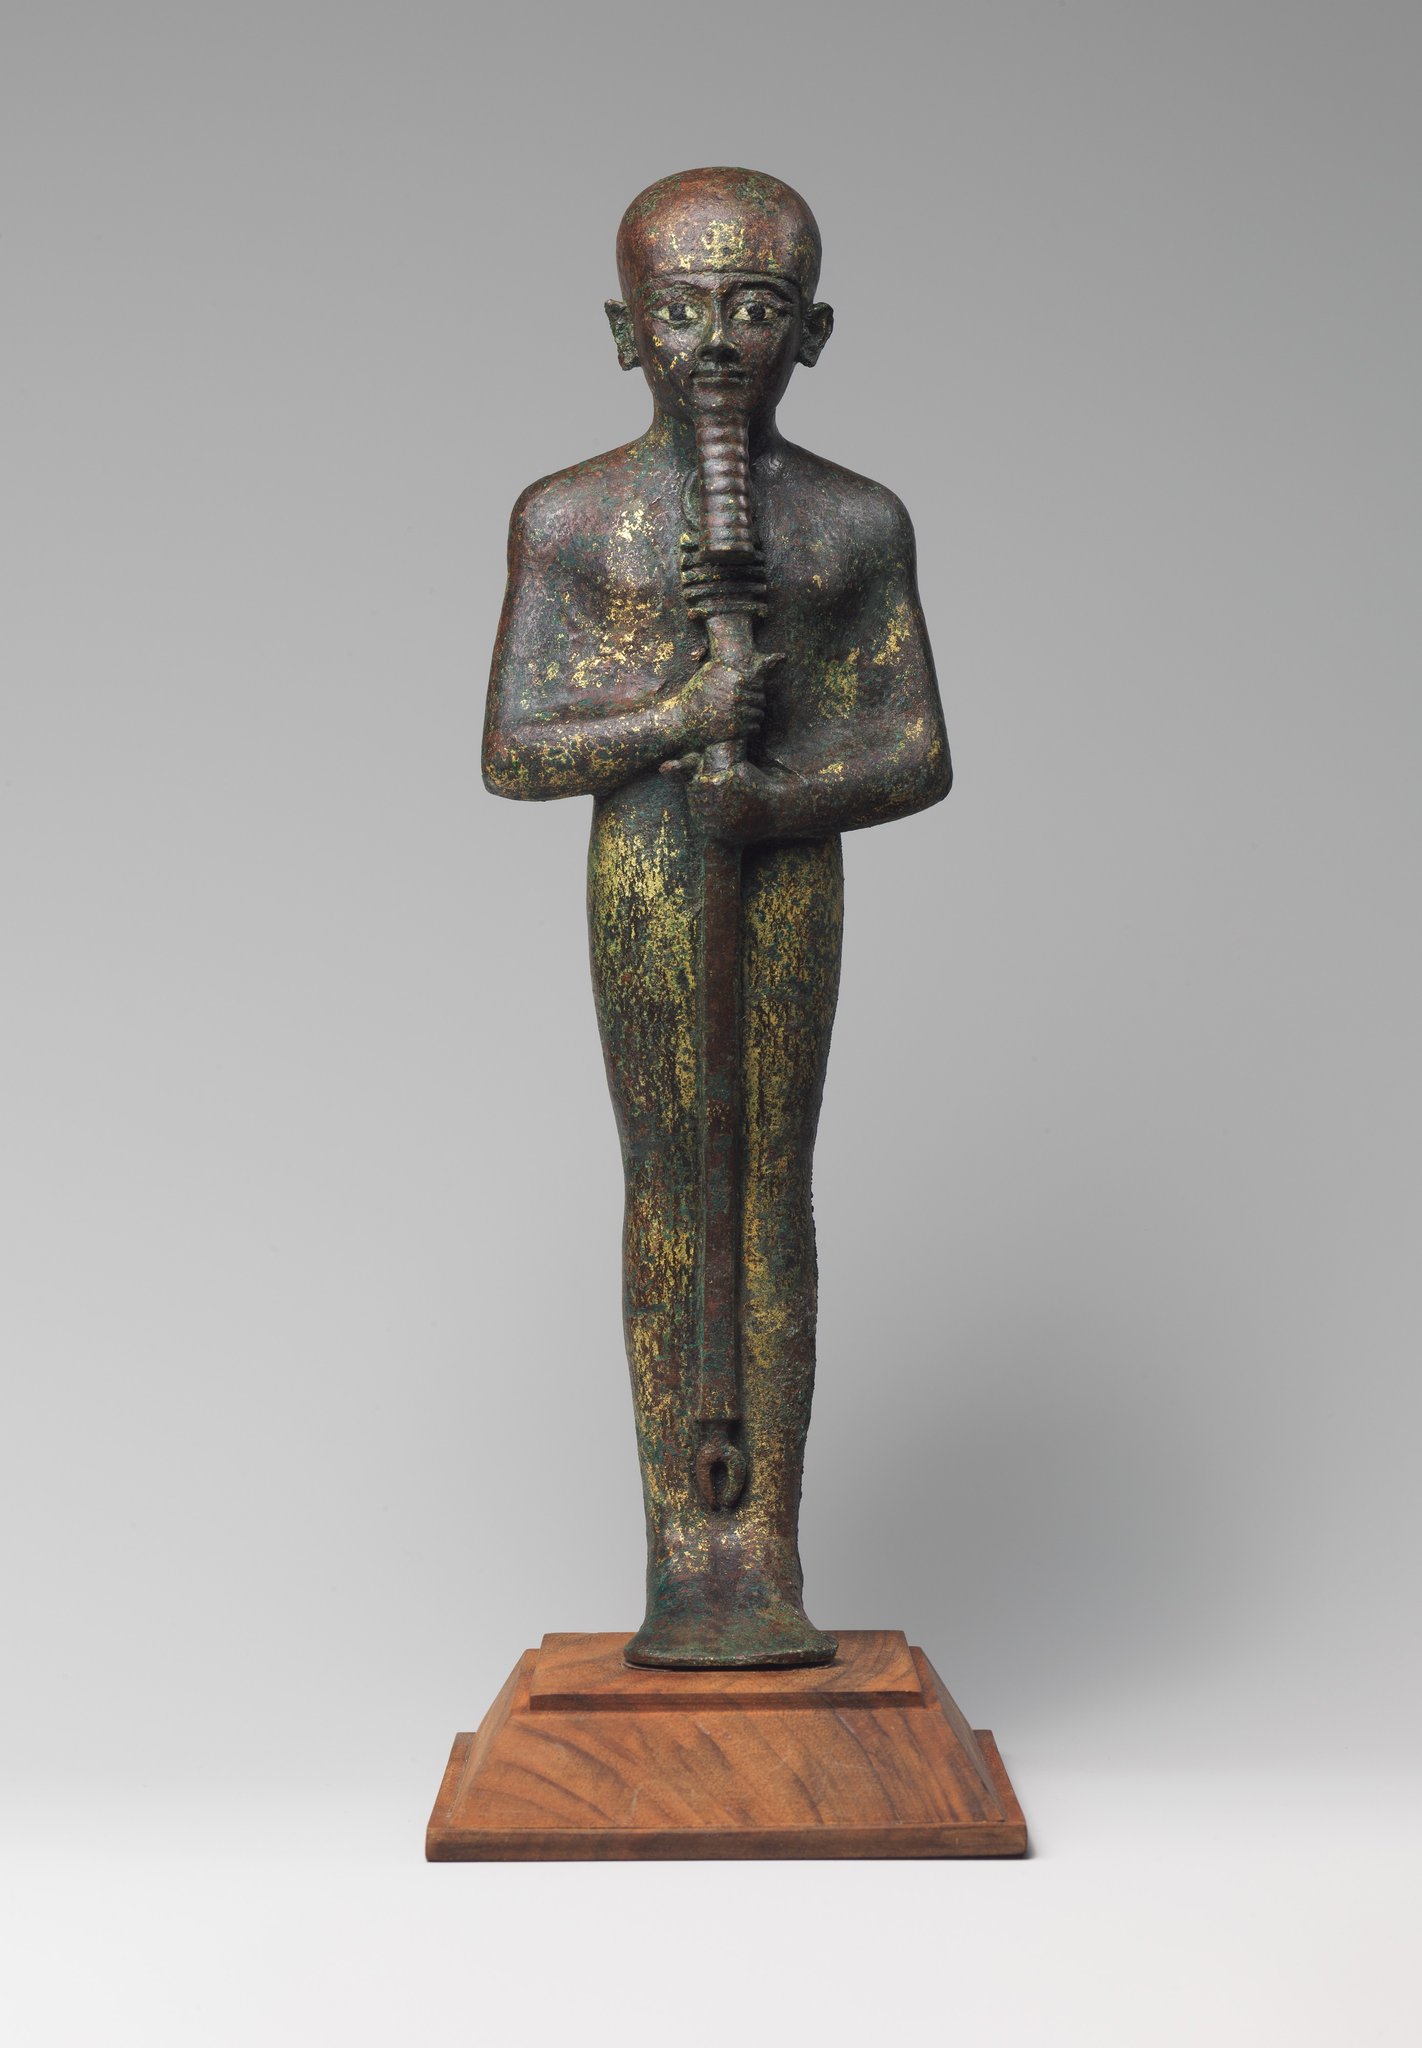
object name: statuette, ptah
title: Statue of the God Ptah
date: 1070-712 BCE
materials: bronze, glass, gold leaf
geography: egypt